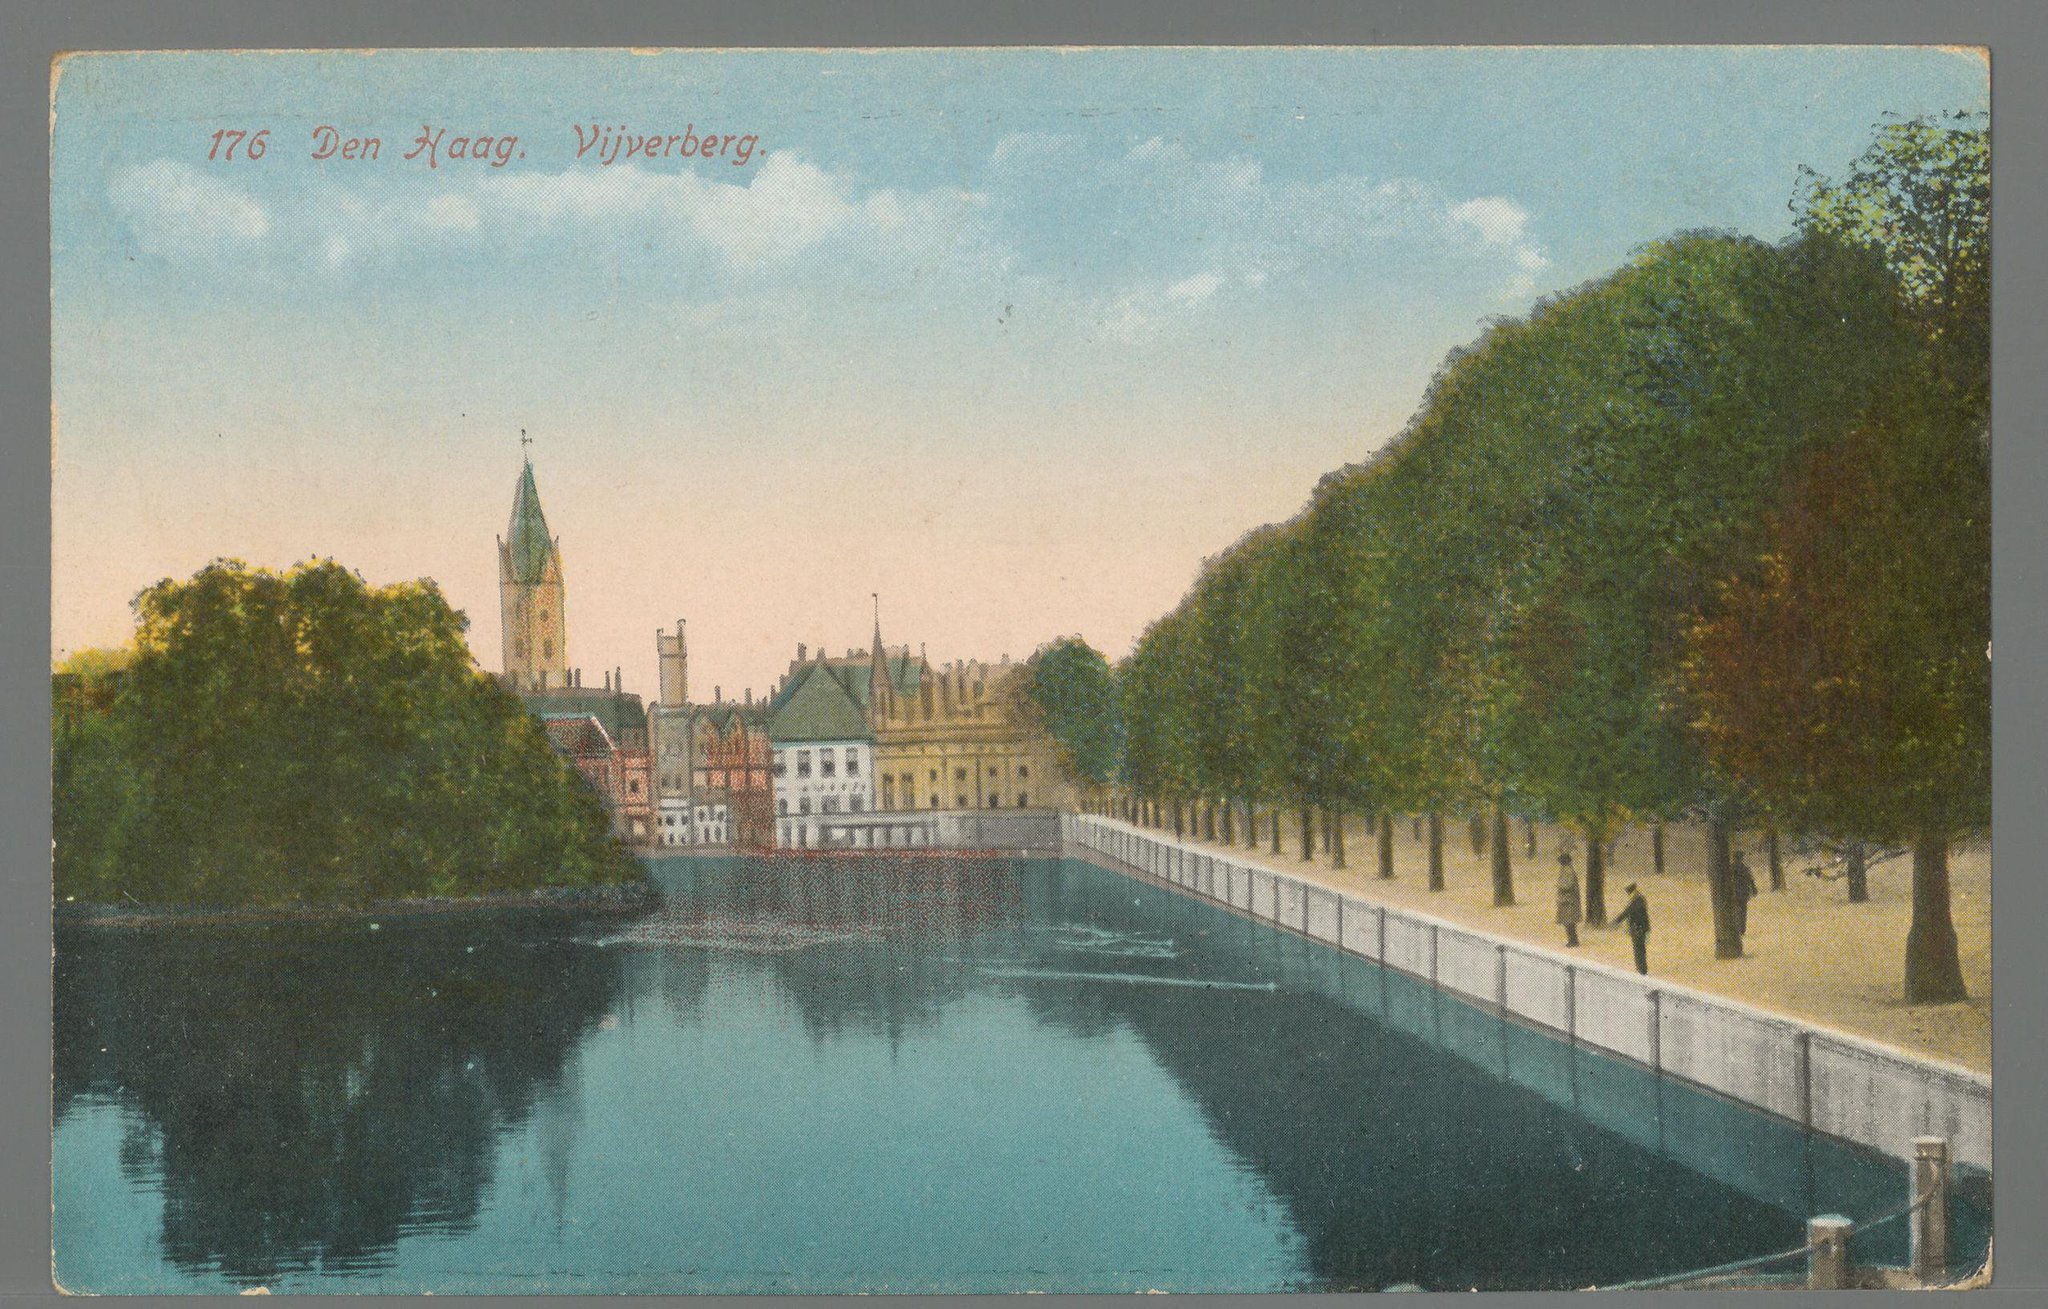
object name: ansichtkaart, prentbriefkaart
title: Den Haag. Vijverberg.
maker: Anonymous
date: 1905-1912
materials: cardboard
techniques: autochrome process, writing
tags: city-view in general; 'veduta', pond, the hague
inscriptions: poststempel, verso, gestempeld